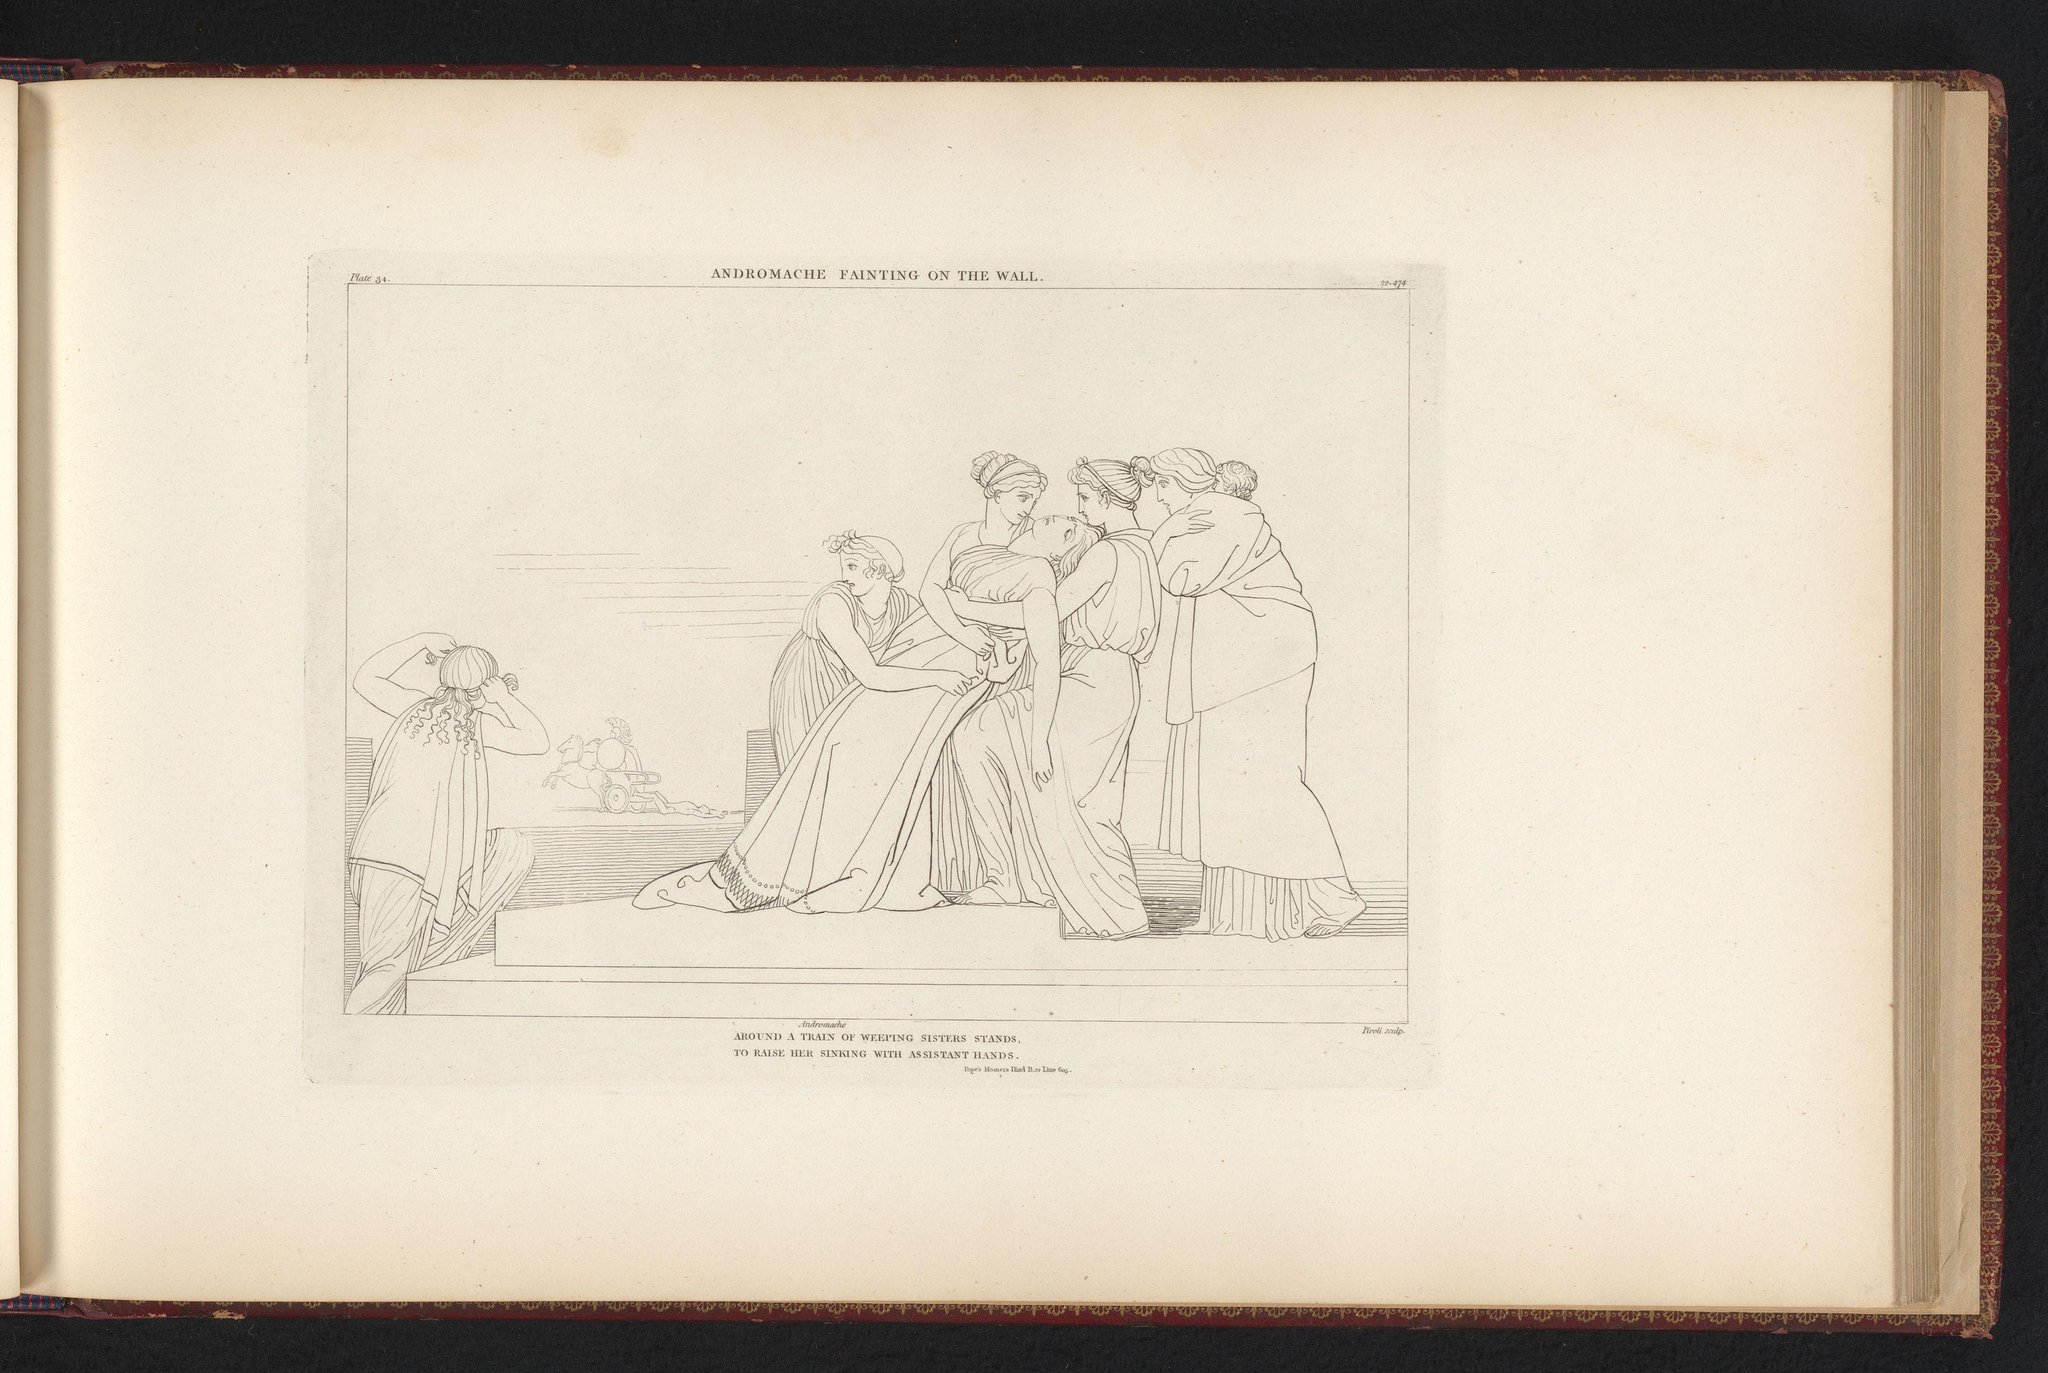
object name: print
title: Andromache valt flauw na Hectors afscheid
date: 1805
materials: paper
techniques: etching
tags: hector's farewell to his wife andromache and his young son astyanax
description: Prent maakt onderdeel uit van een serie met 39 prenten over de Ilias, geschreven door Homerus.